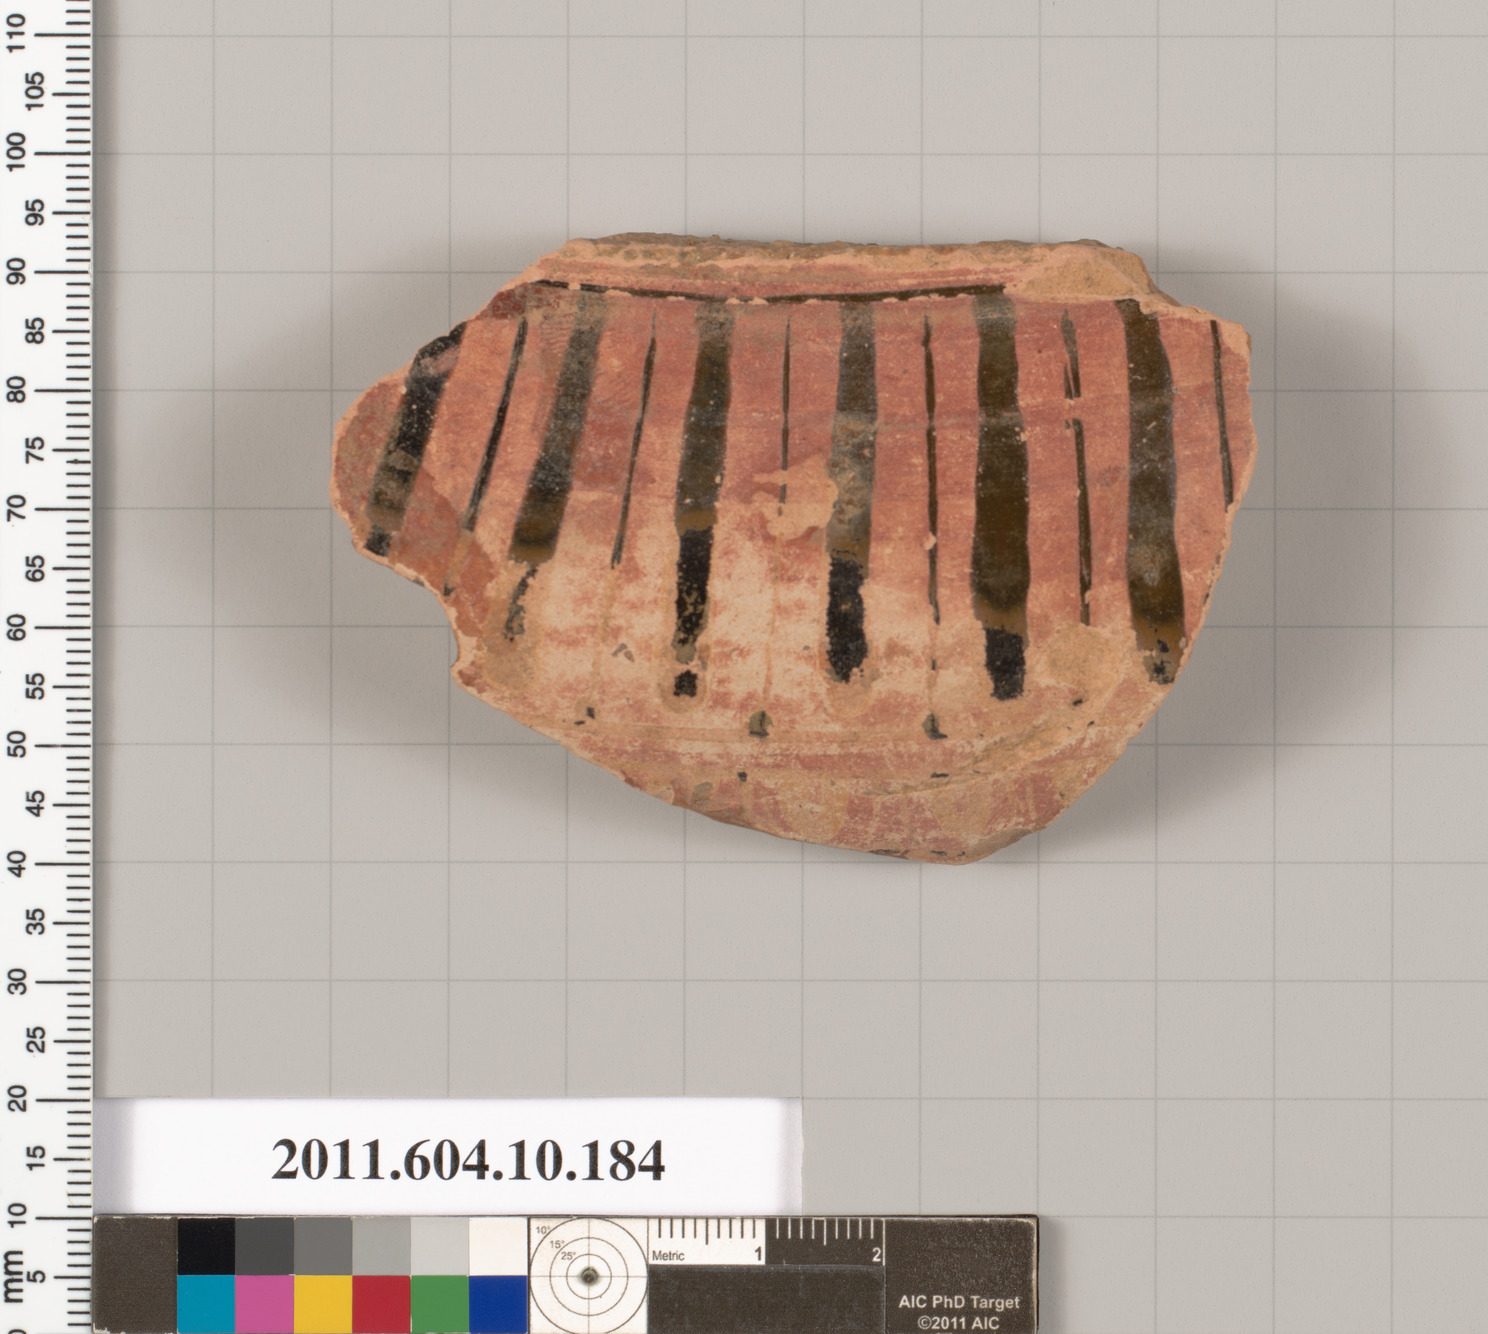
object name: stamnos fragment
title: Terracotta fragment of a stamnos (jar)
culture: etruscan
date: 534-468 BCE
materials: terracotta